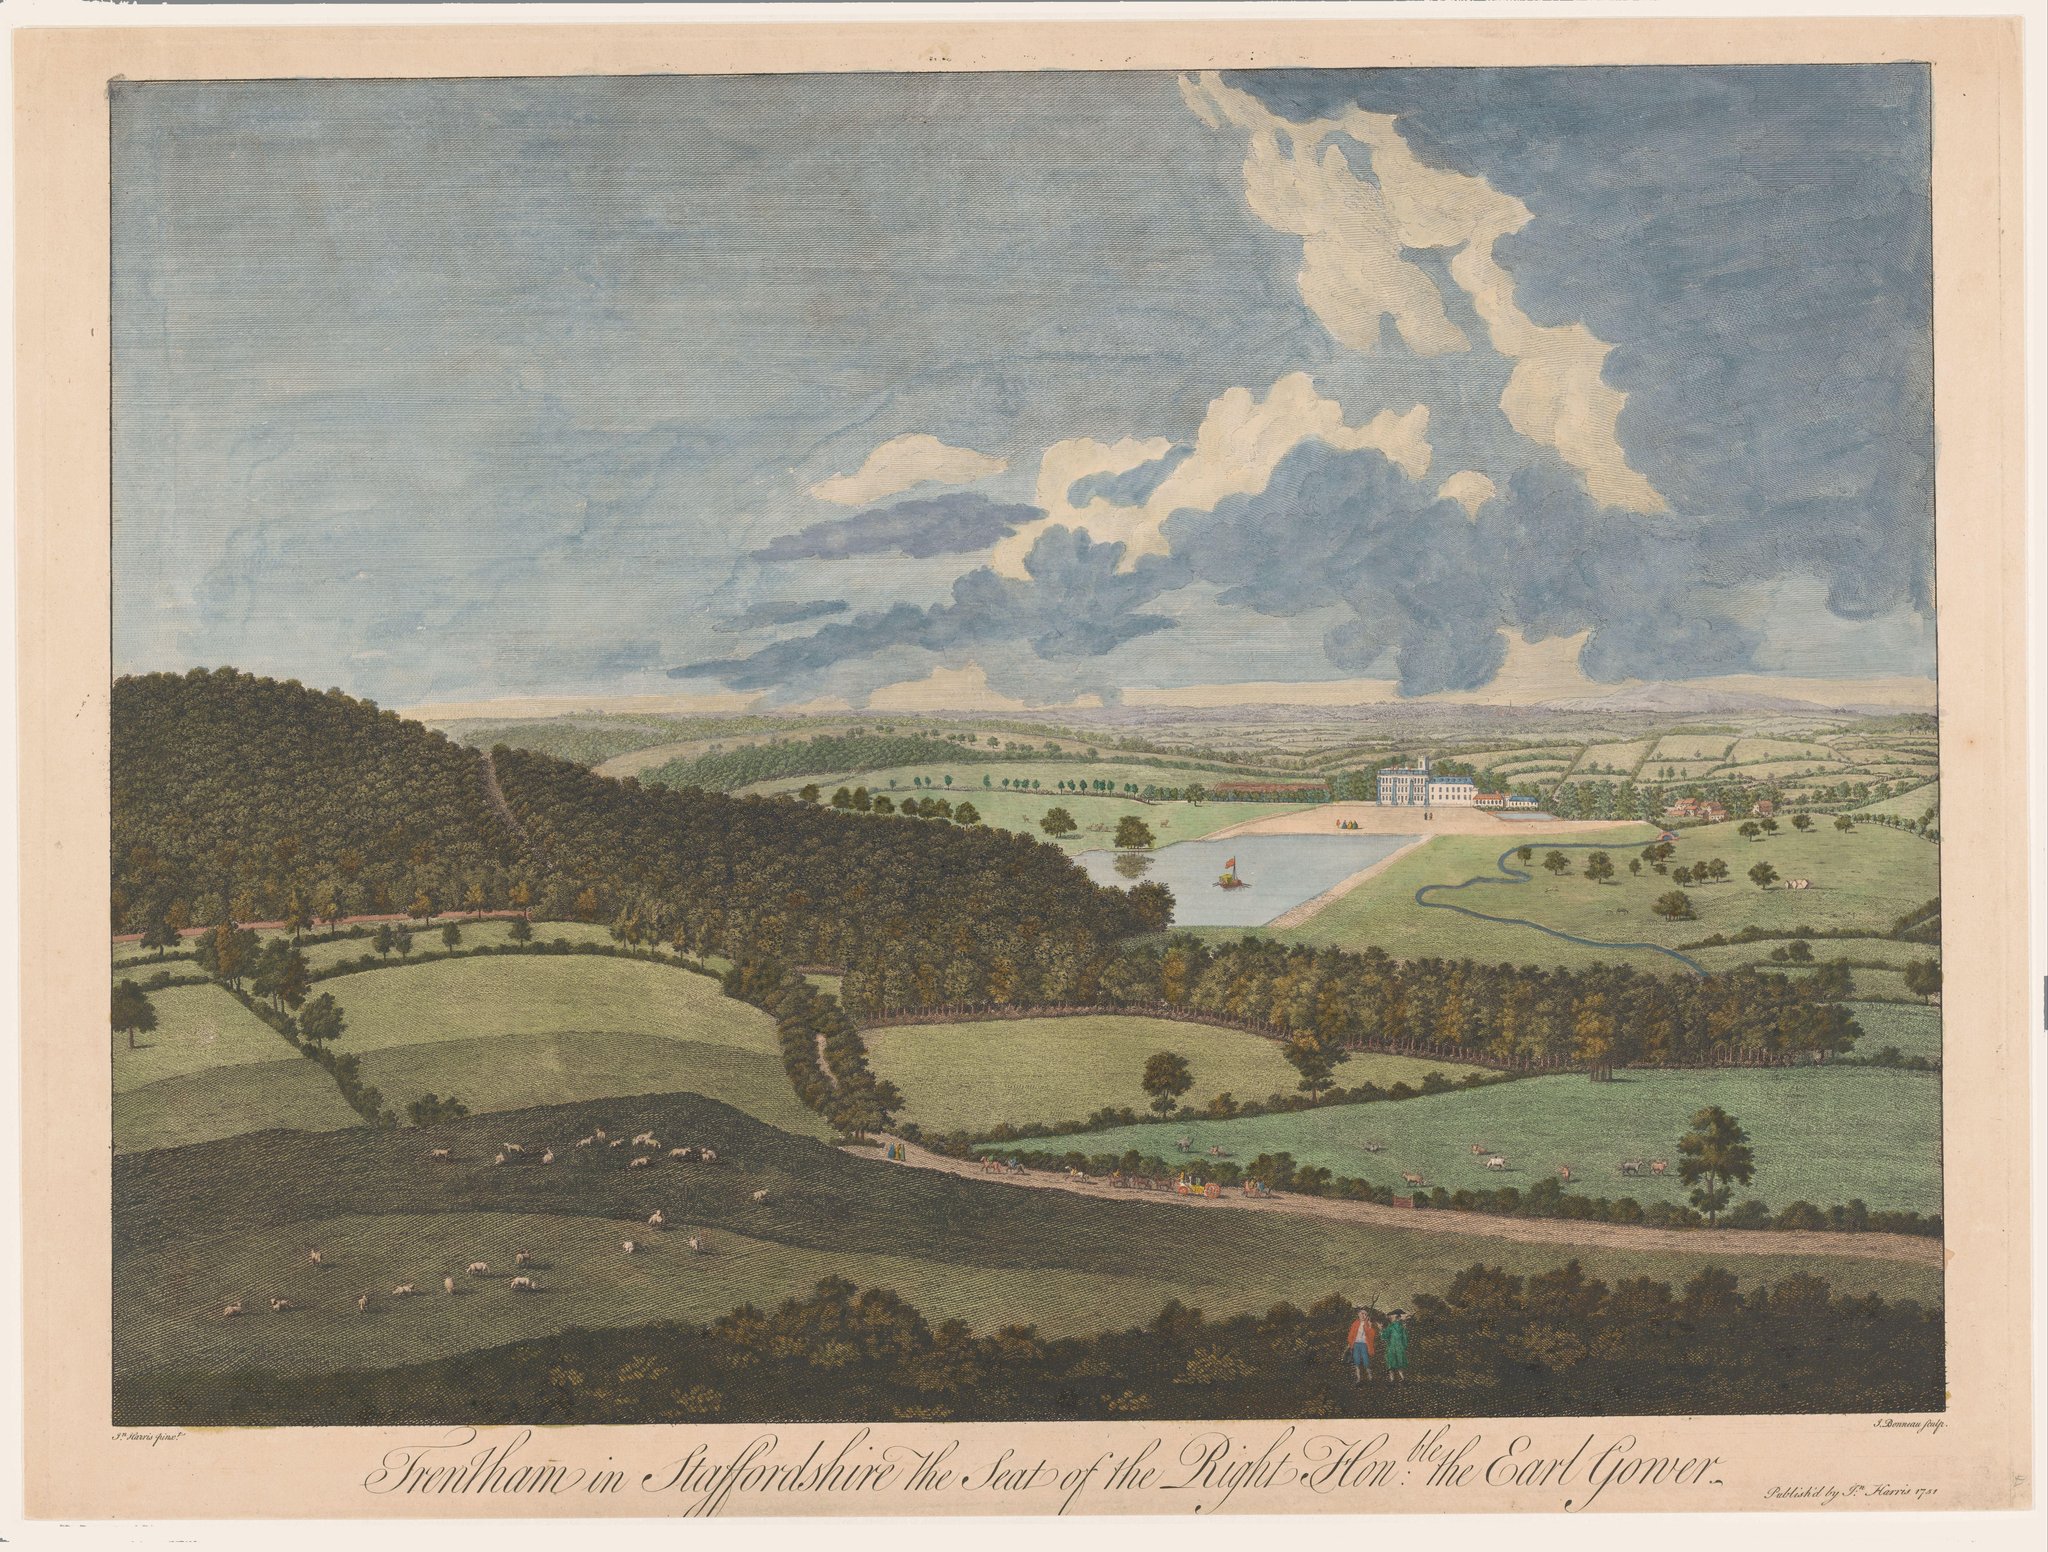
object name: print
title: Gezicht op Trentham in Staffordshire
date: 1731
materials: paper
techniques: etching, hand coloring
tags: low hill country (+ landscape with figures, staffage), country-house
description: Maakt mogelijk onderdeel uit van een serie met een object in de collectie van het Rijksmuseum, inv. nr.: RP-P-OB-22.477.